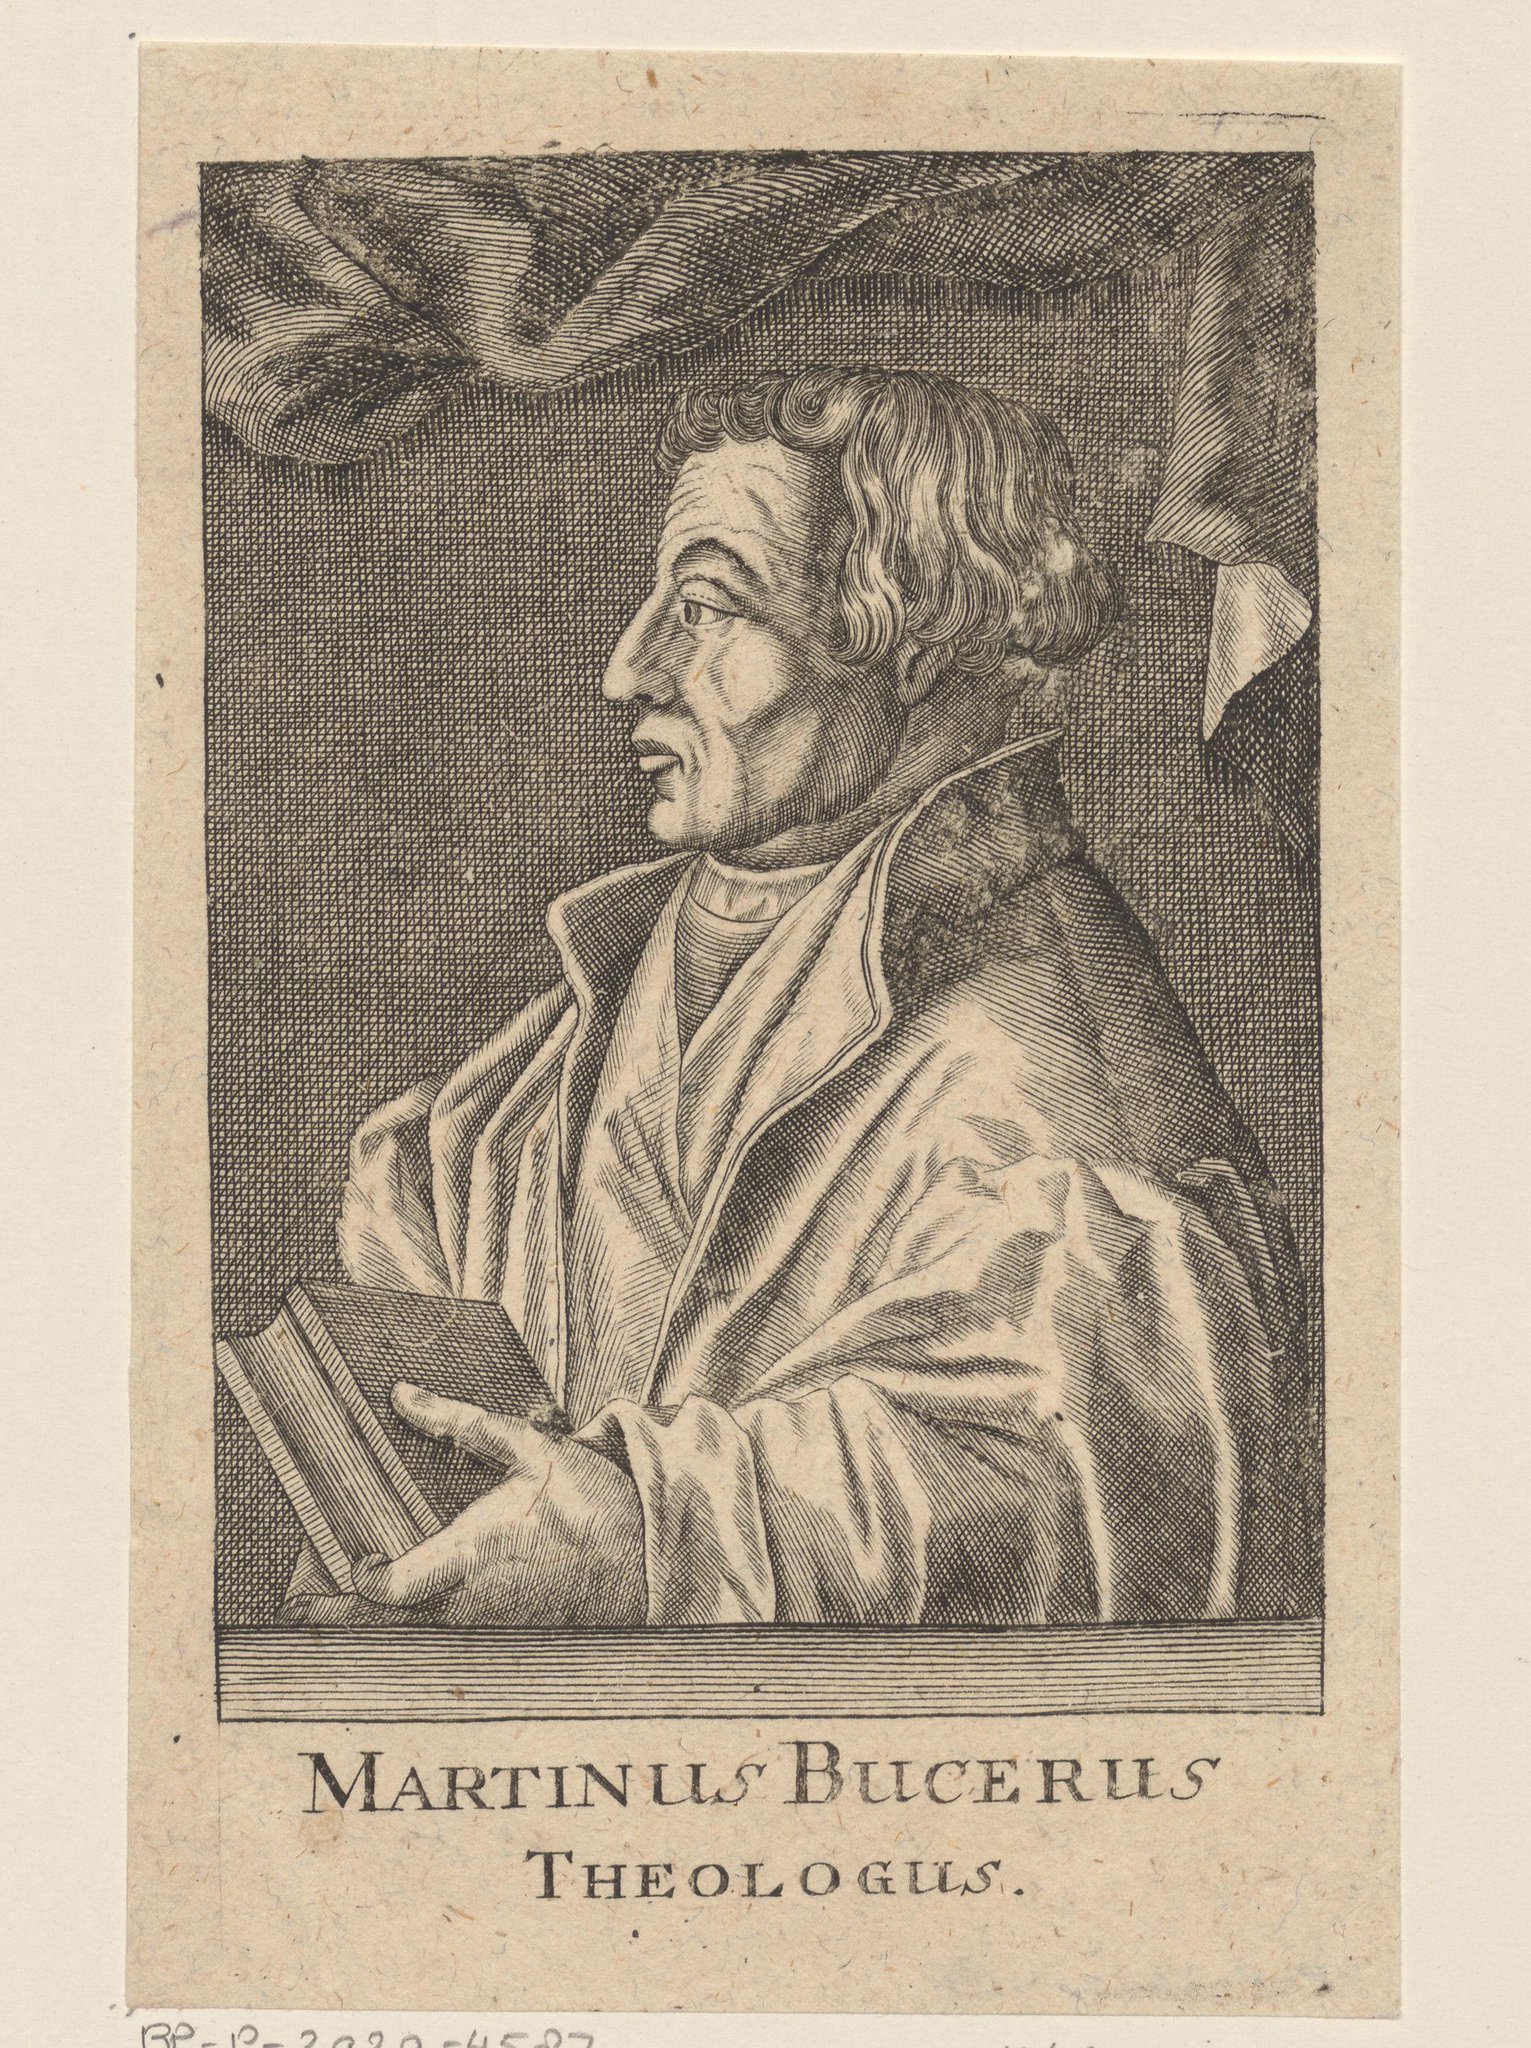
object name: print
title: Portret van Martin Bucer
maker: Anonymous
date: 1700-1749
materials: paper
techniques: engraving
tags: theologian, historical persons, book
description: Prent mogelijk uit: Fortgesetzte Sammlung von Alten und Neuen Theologischen Sachen (...). Leipzig: erven Johann Friedrich Braun, 1730.